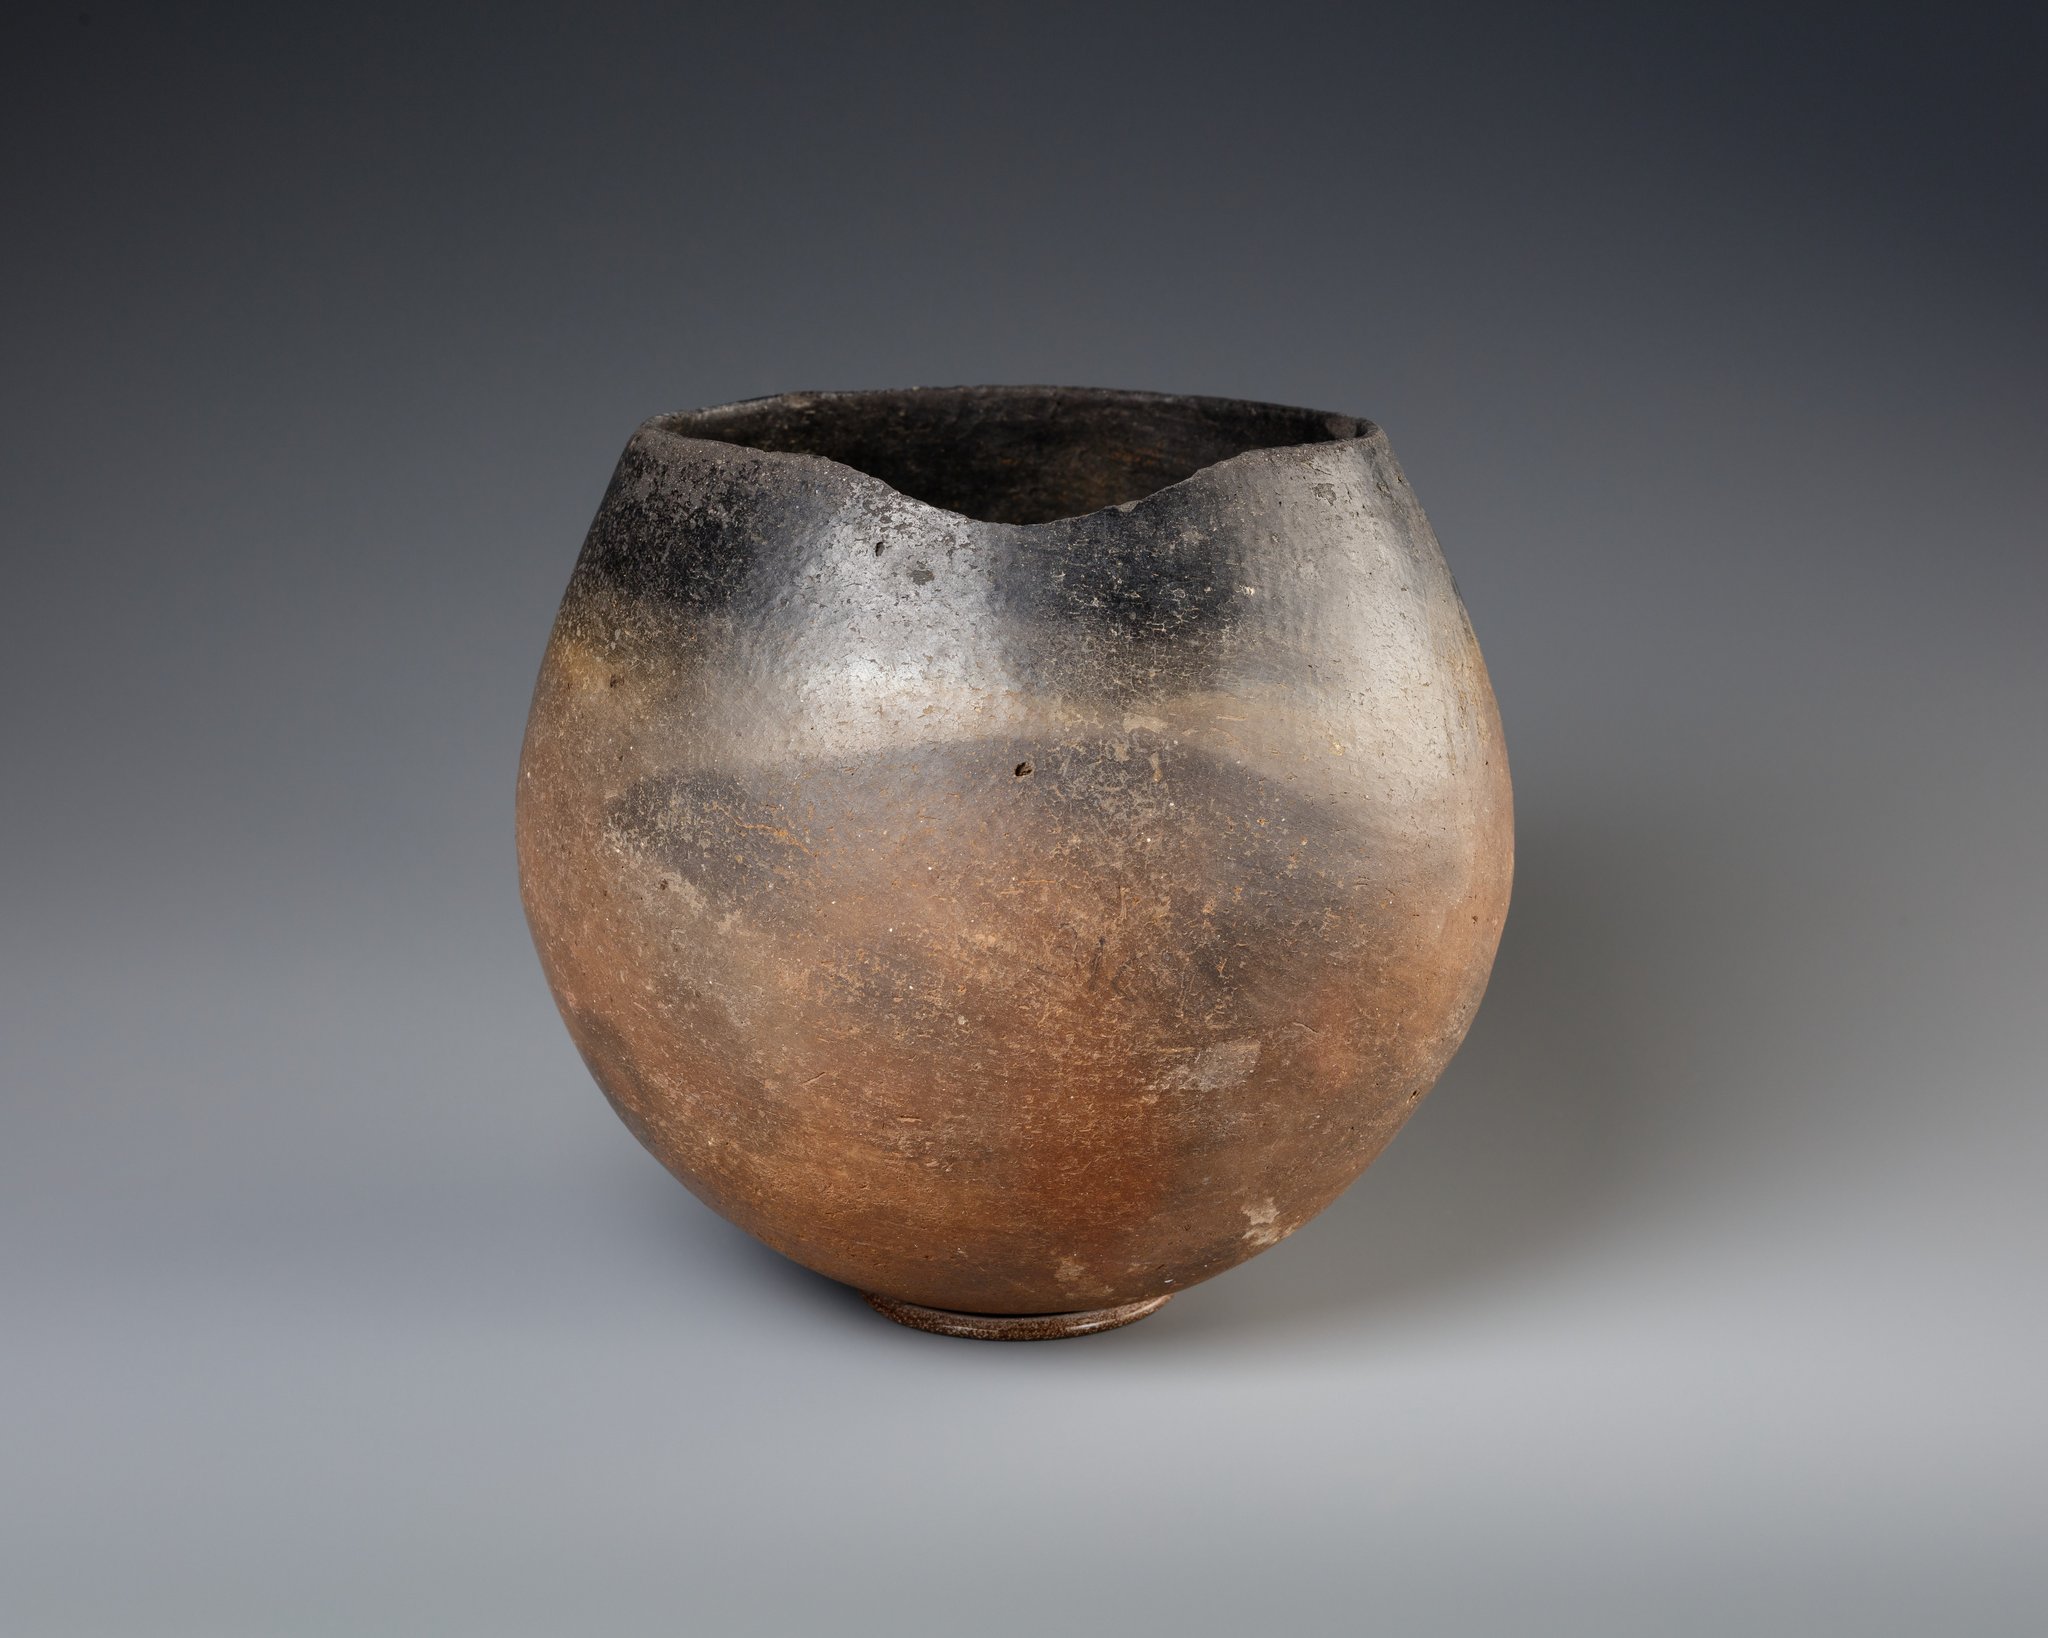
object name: bowl, black topped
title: Black-topped brown ware bowl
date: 4500-4000 BCE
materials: pottery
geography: egypt